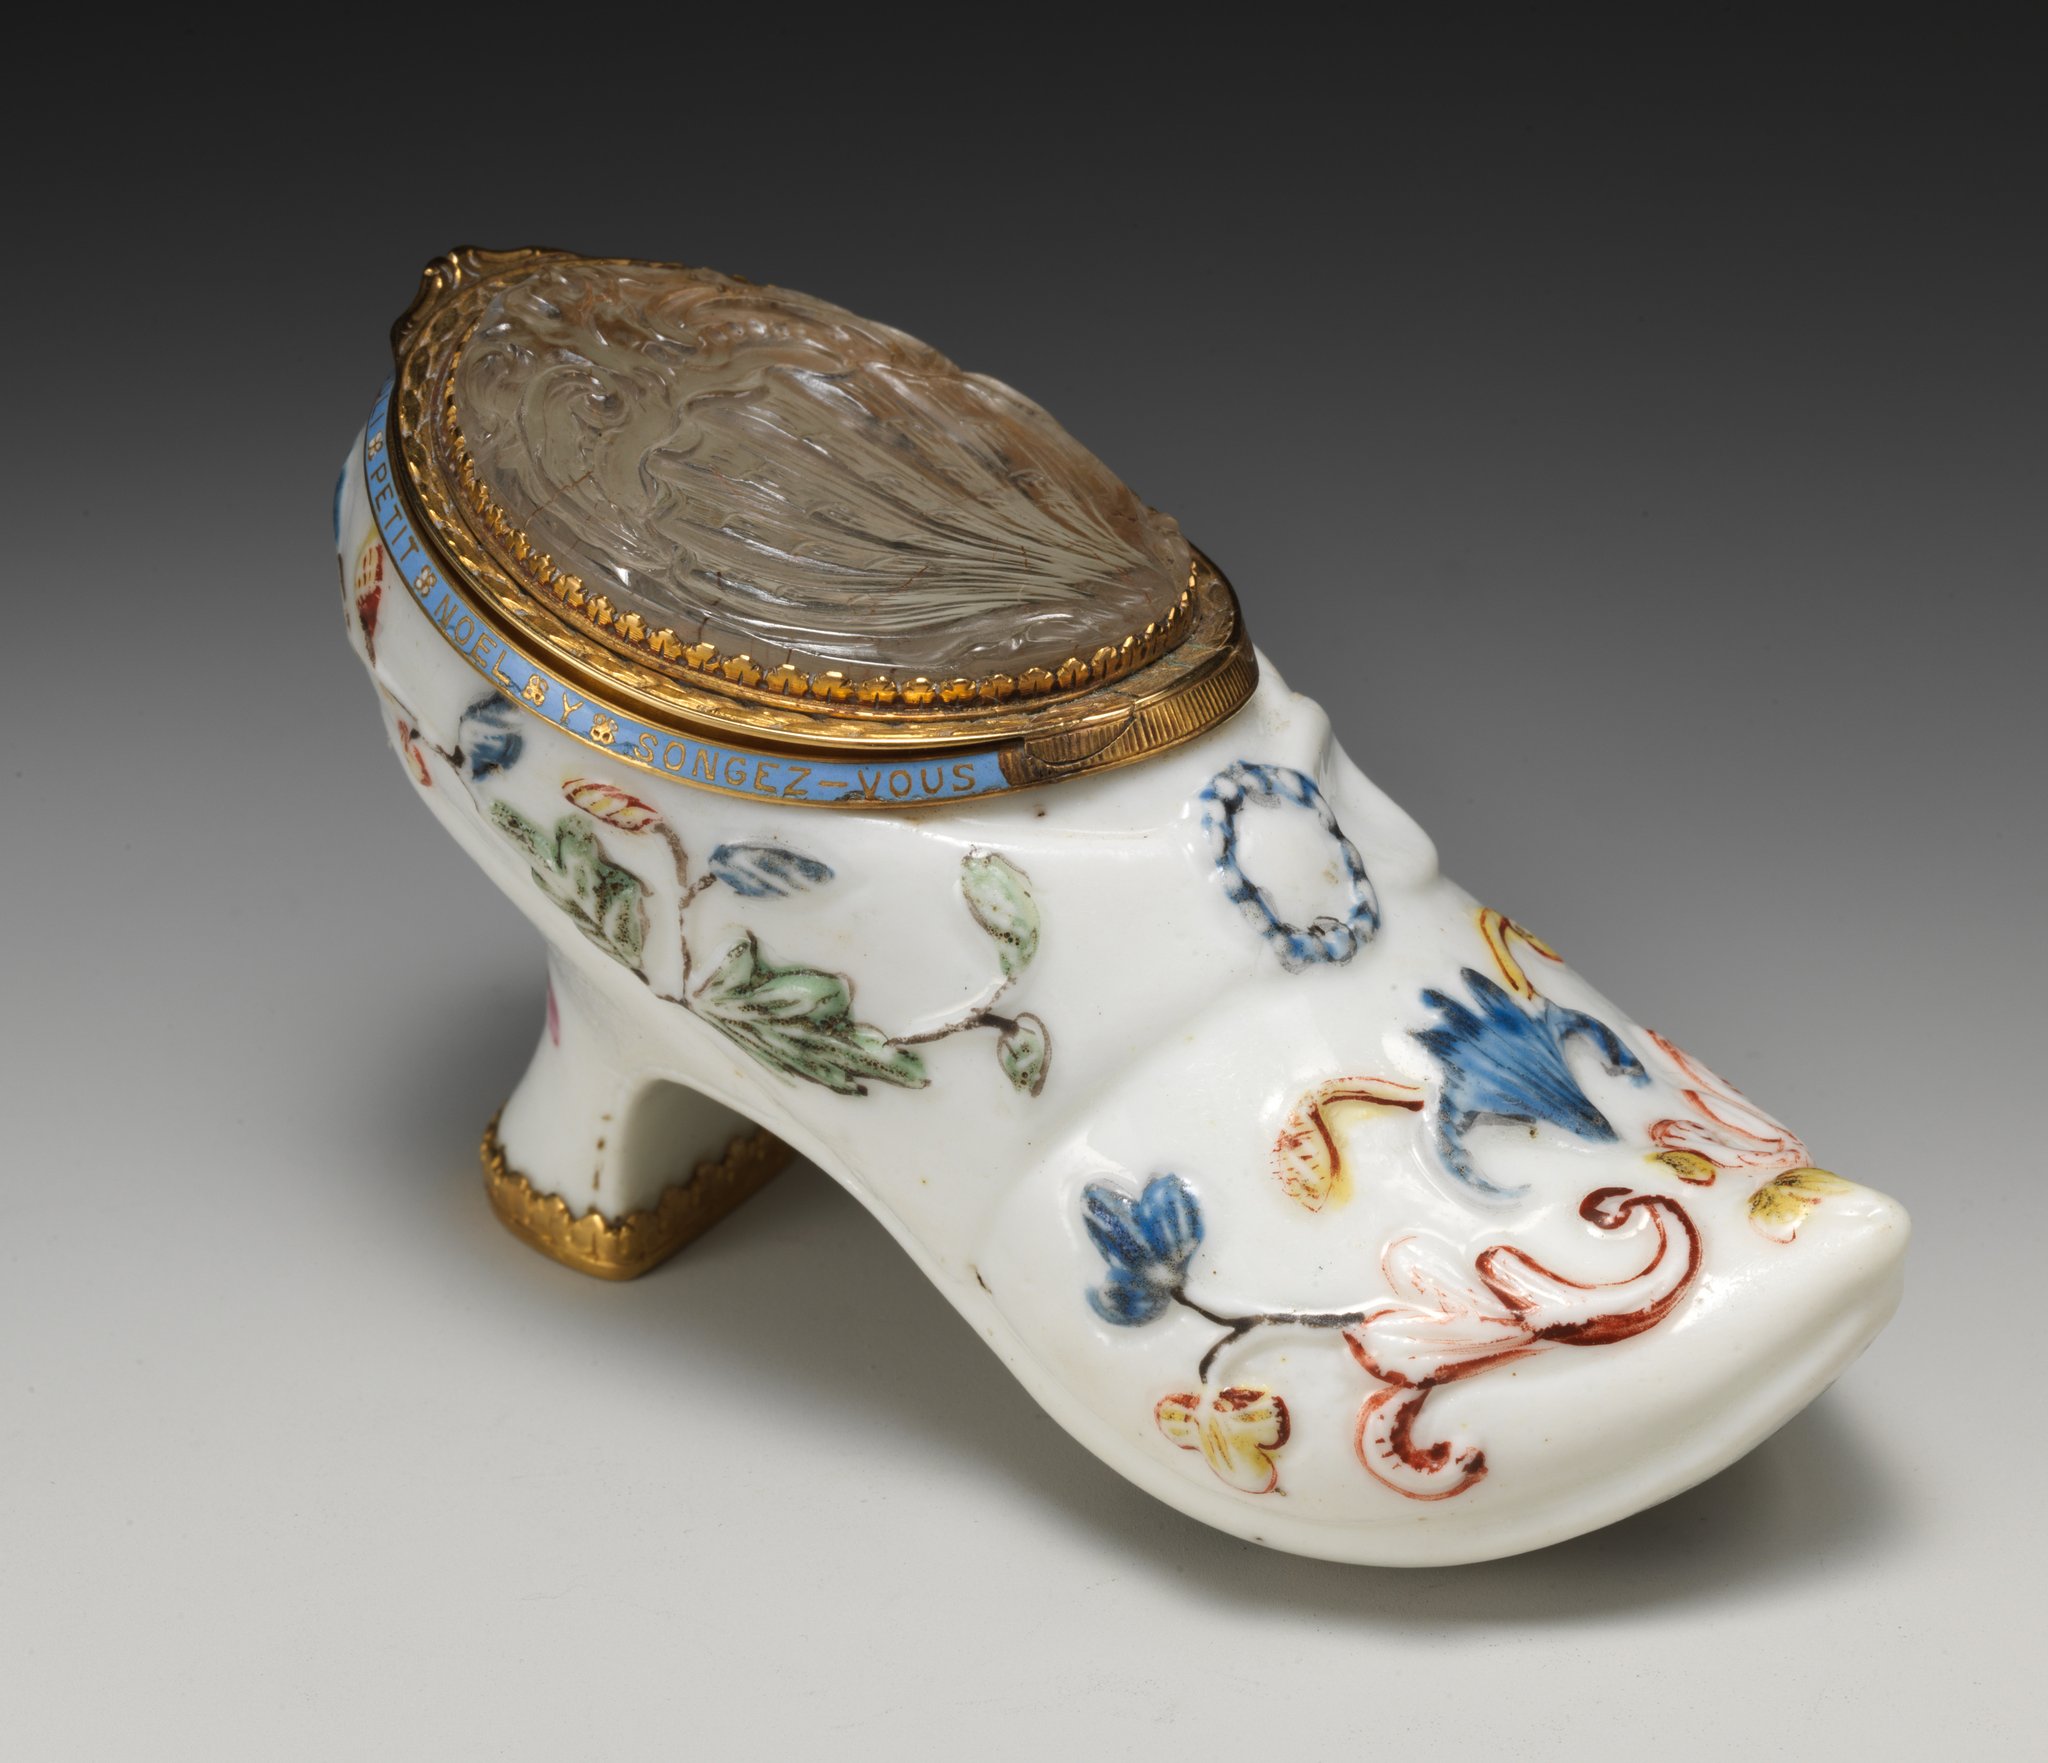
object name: box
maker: mennecy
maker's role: factory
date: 1750-1760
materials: enamel, gold, soft paste porcelain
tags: leaves